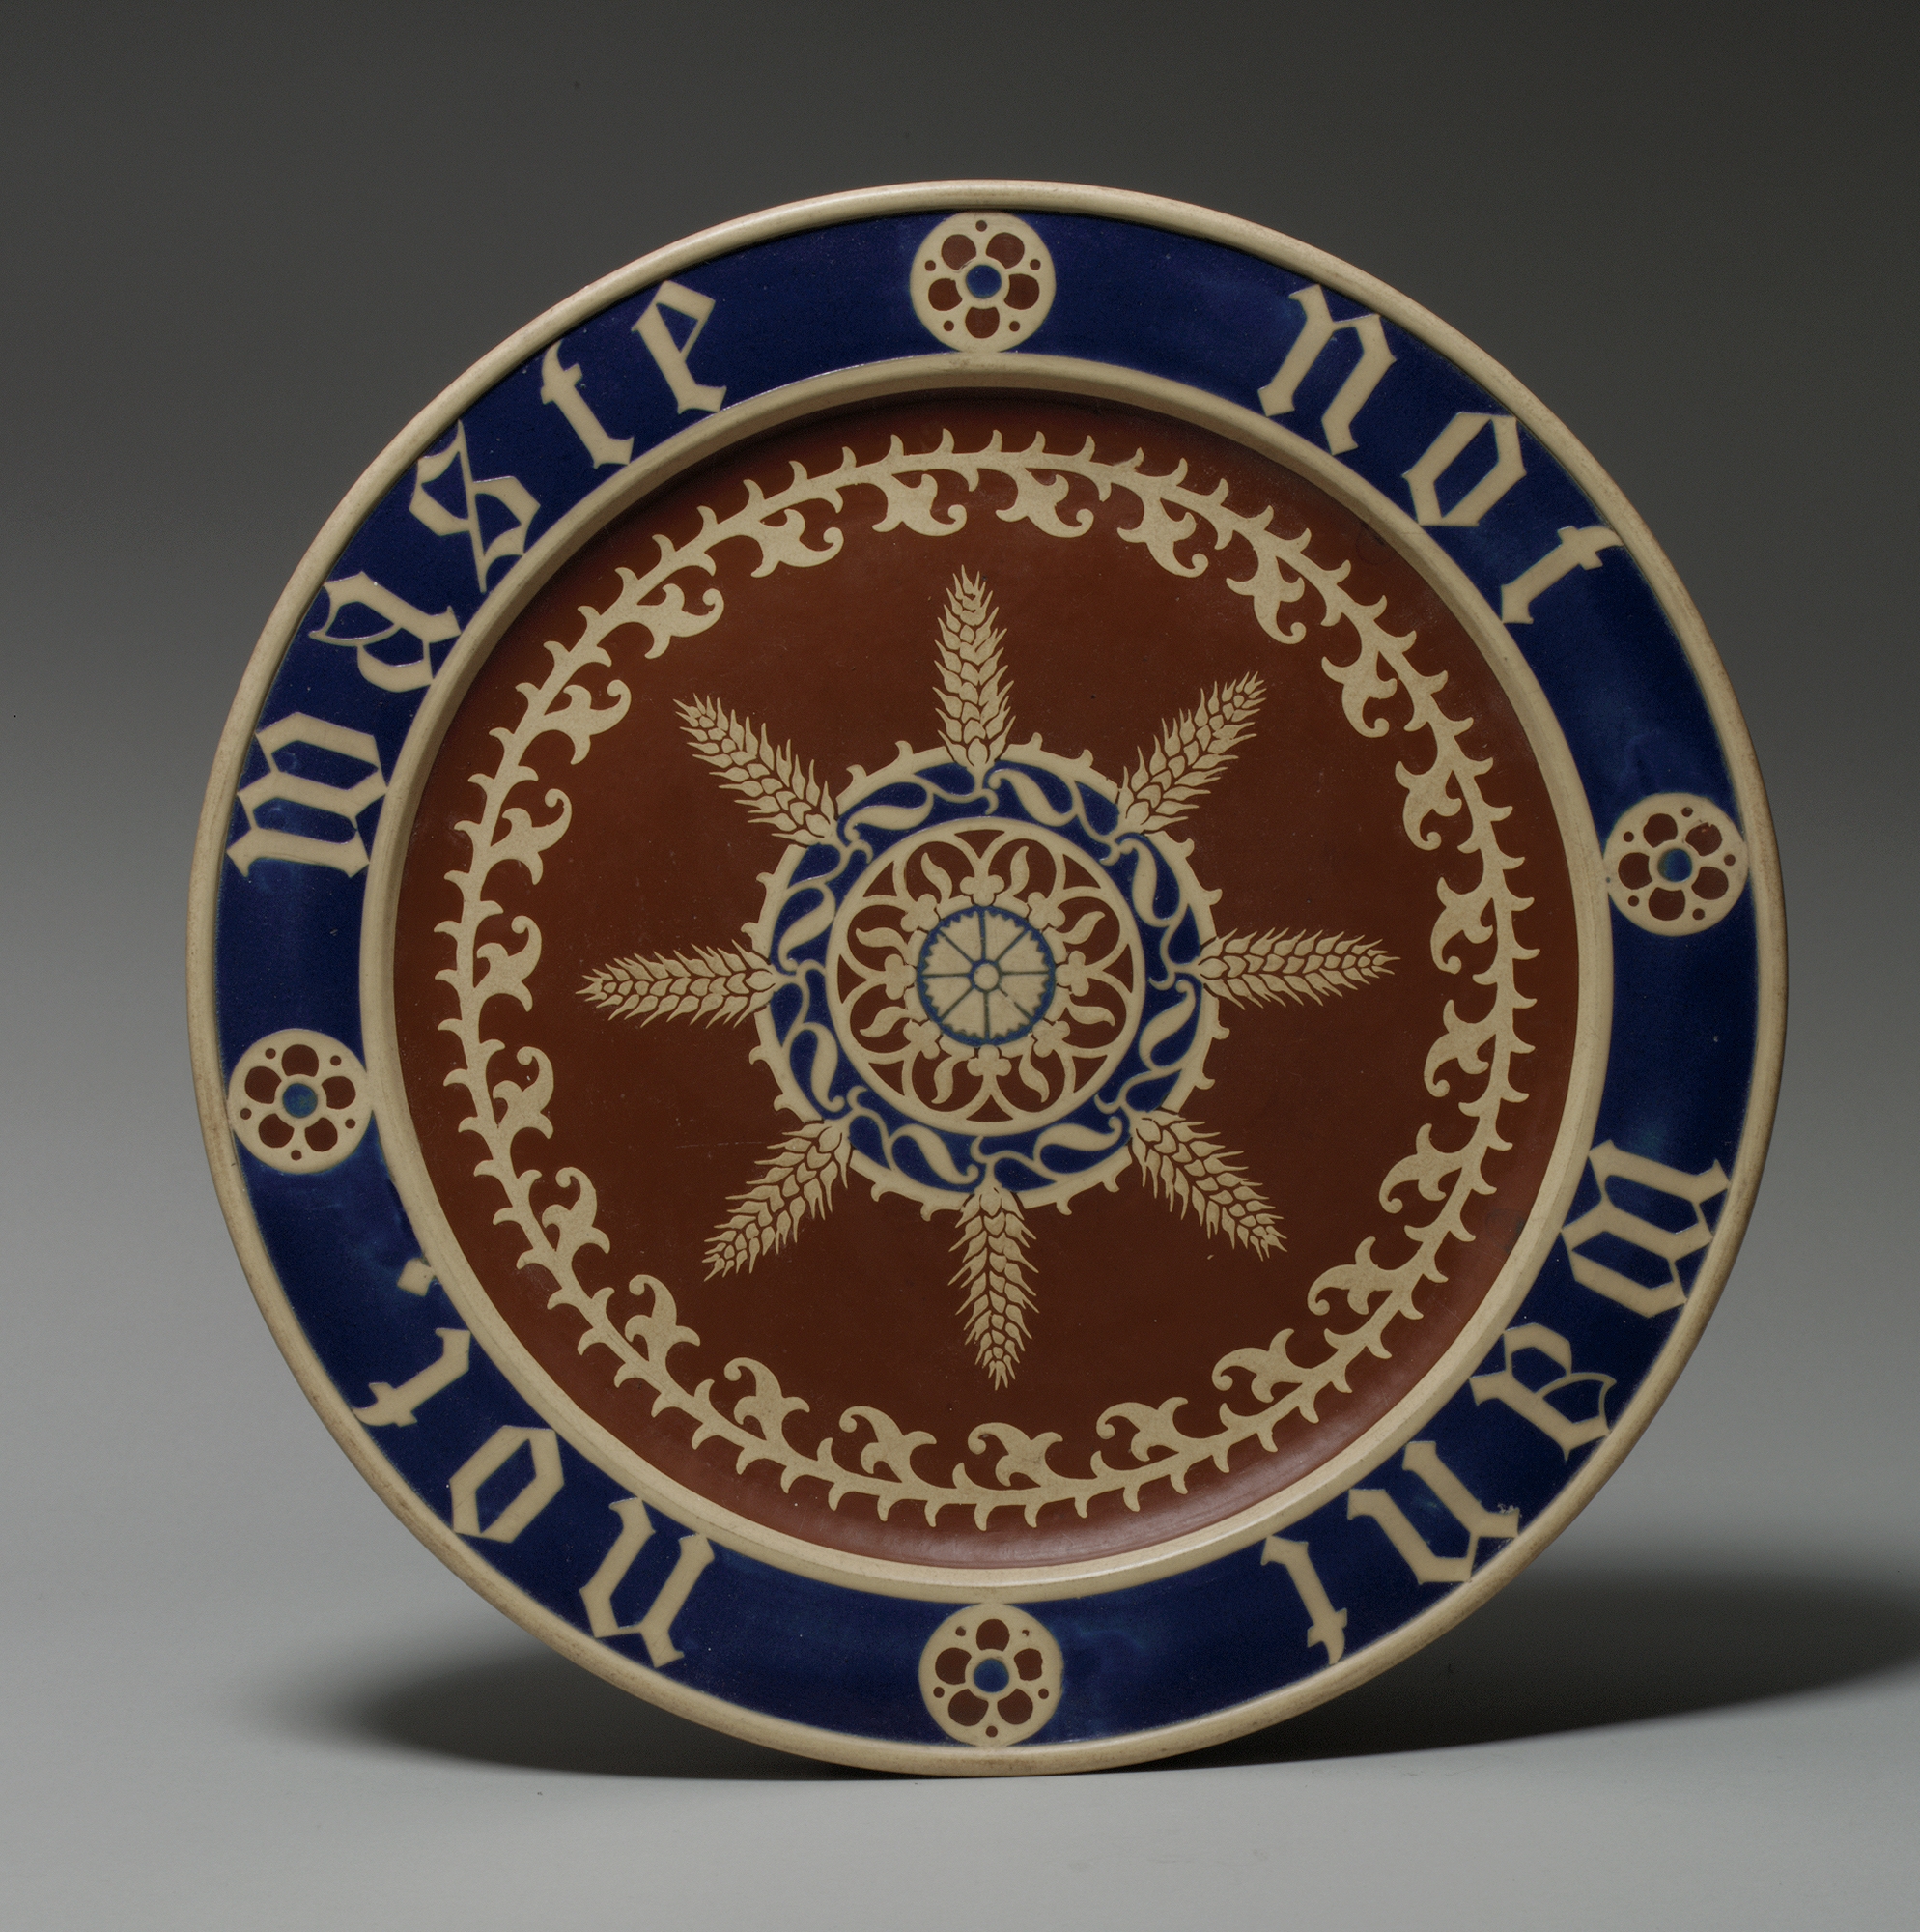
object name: bread plate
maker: augustus welby northmore pugin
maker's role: designer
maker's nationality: british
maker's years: 1812-1852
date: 1850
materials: earthenware